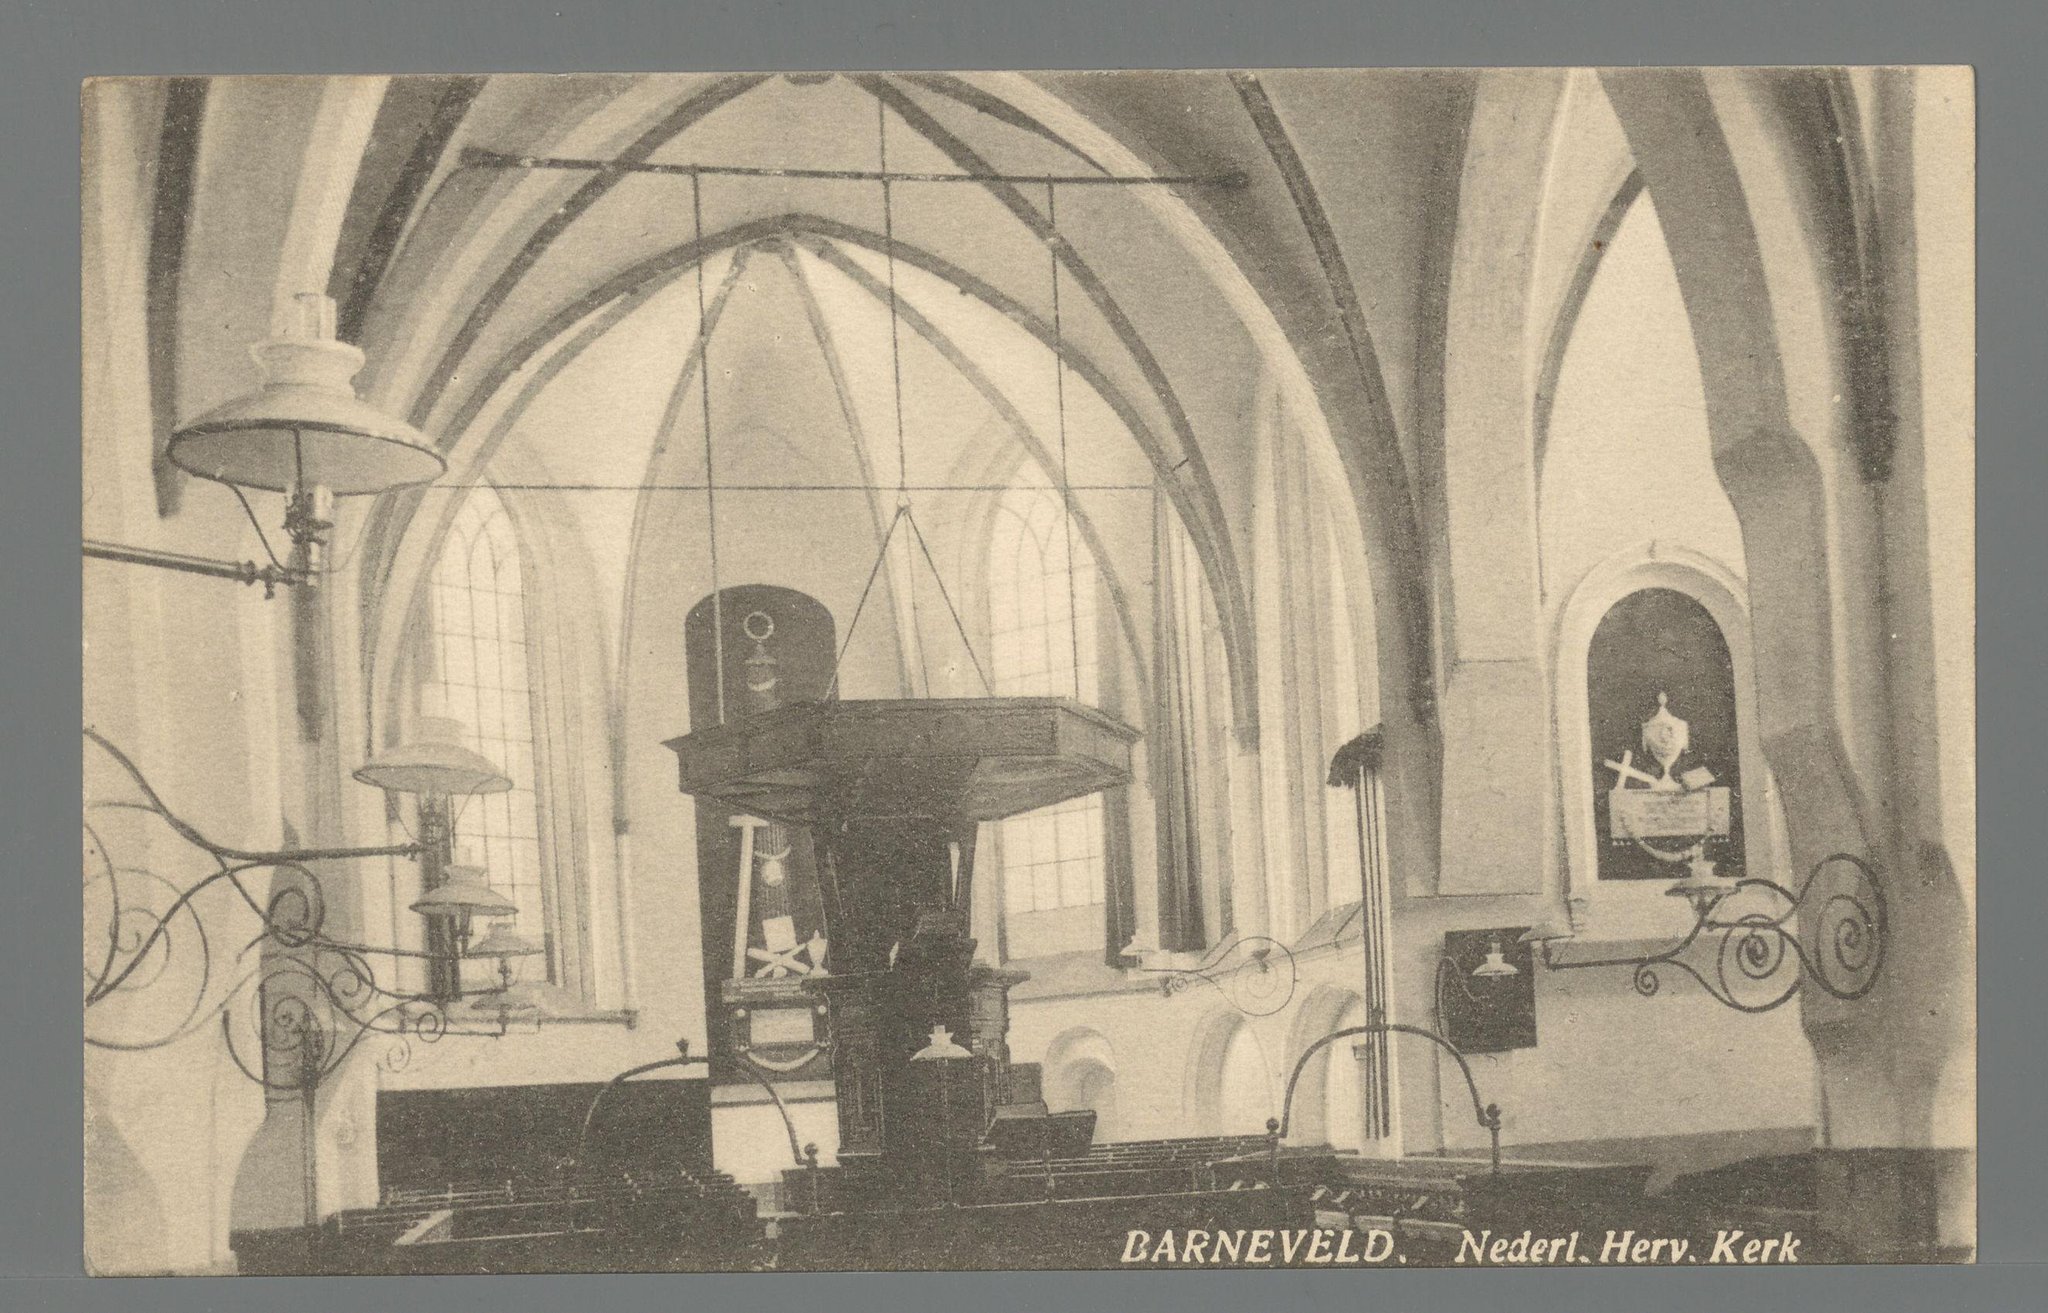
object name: ansichtkaart, prentbriefkaart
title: Barneveld. Nederl. Herv. Kerk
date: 1905-1930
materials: cardboard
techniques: photograph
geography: barneveld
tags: interior of church, pulpit, ambo, chancel